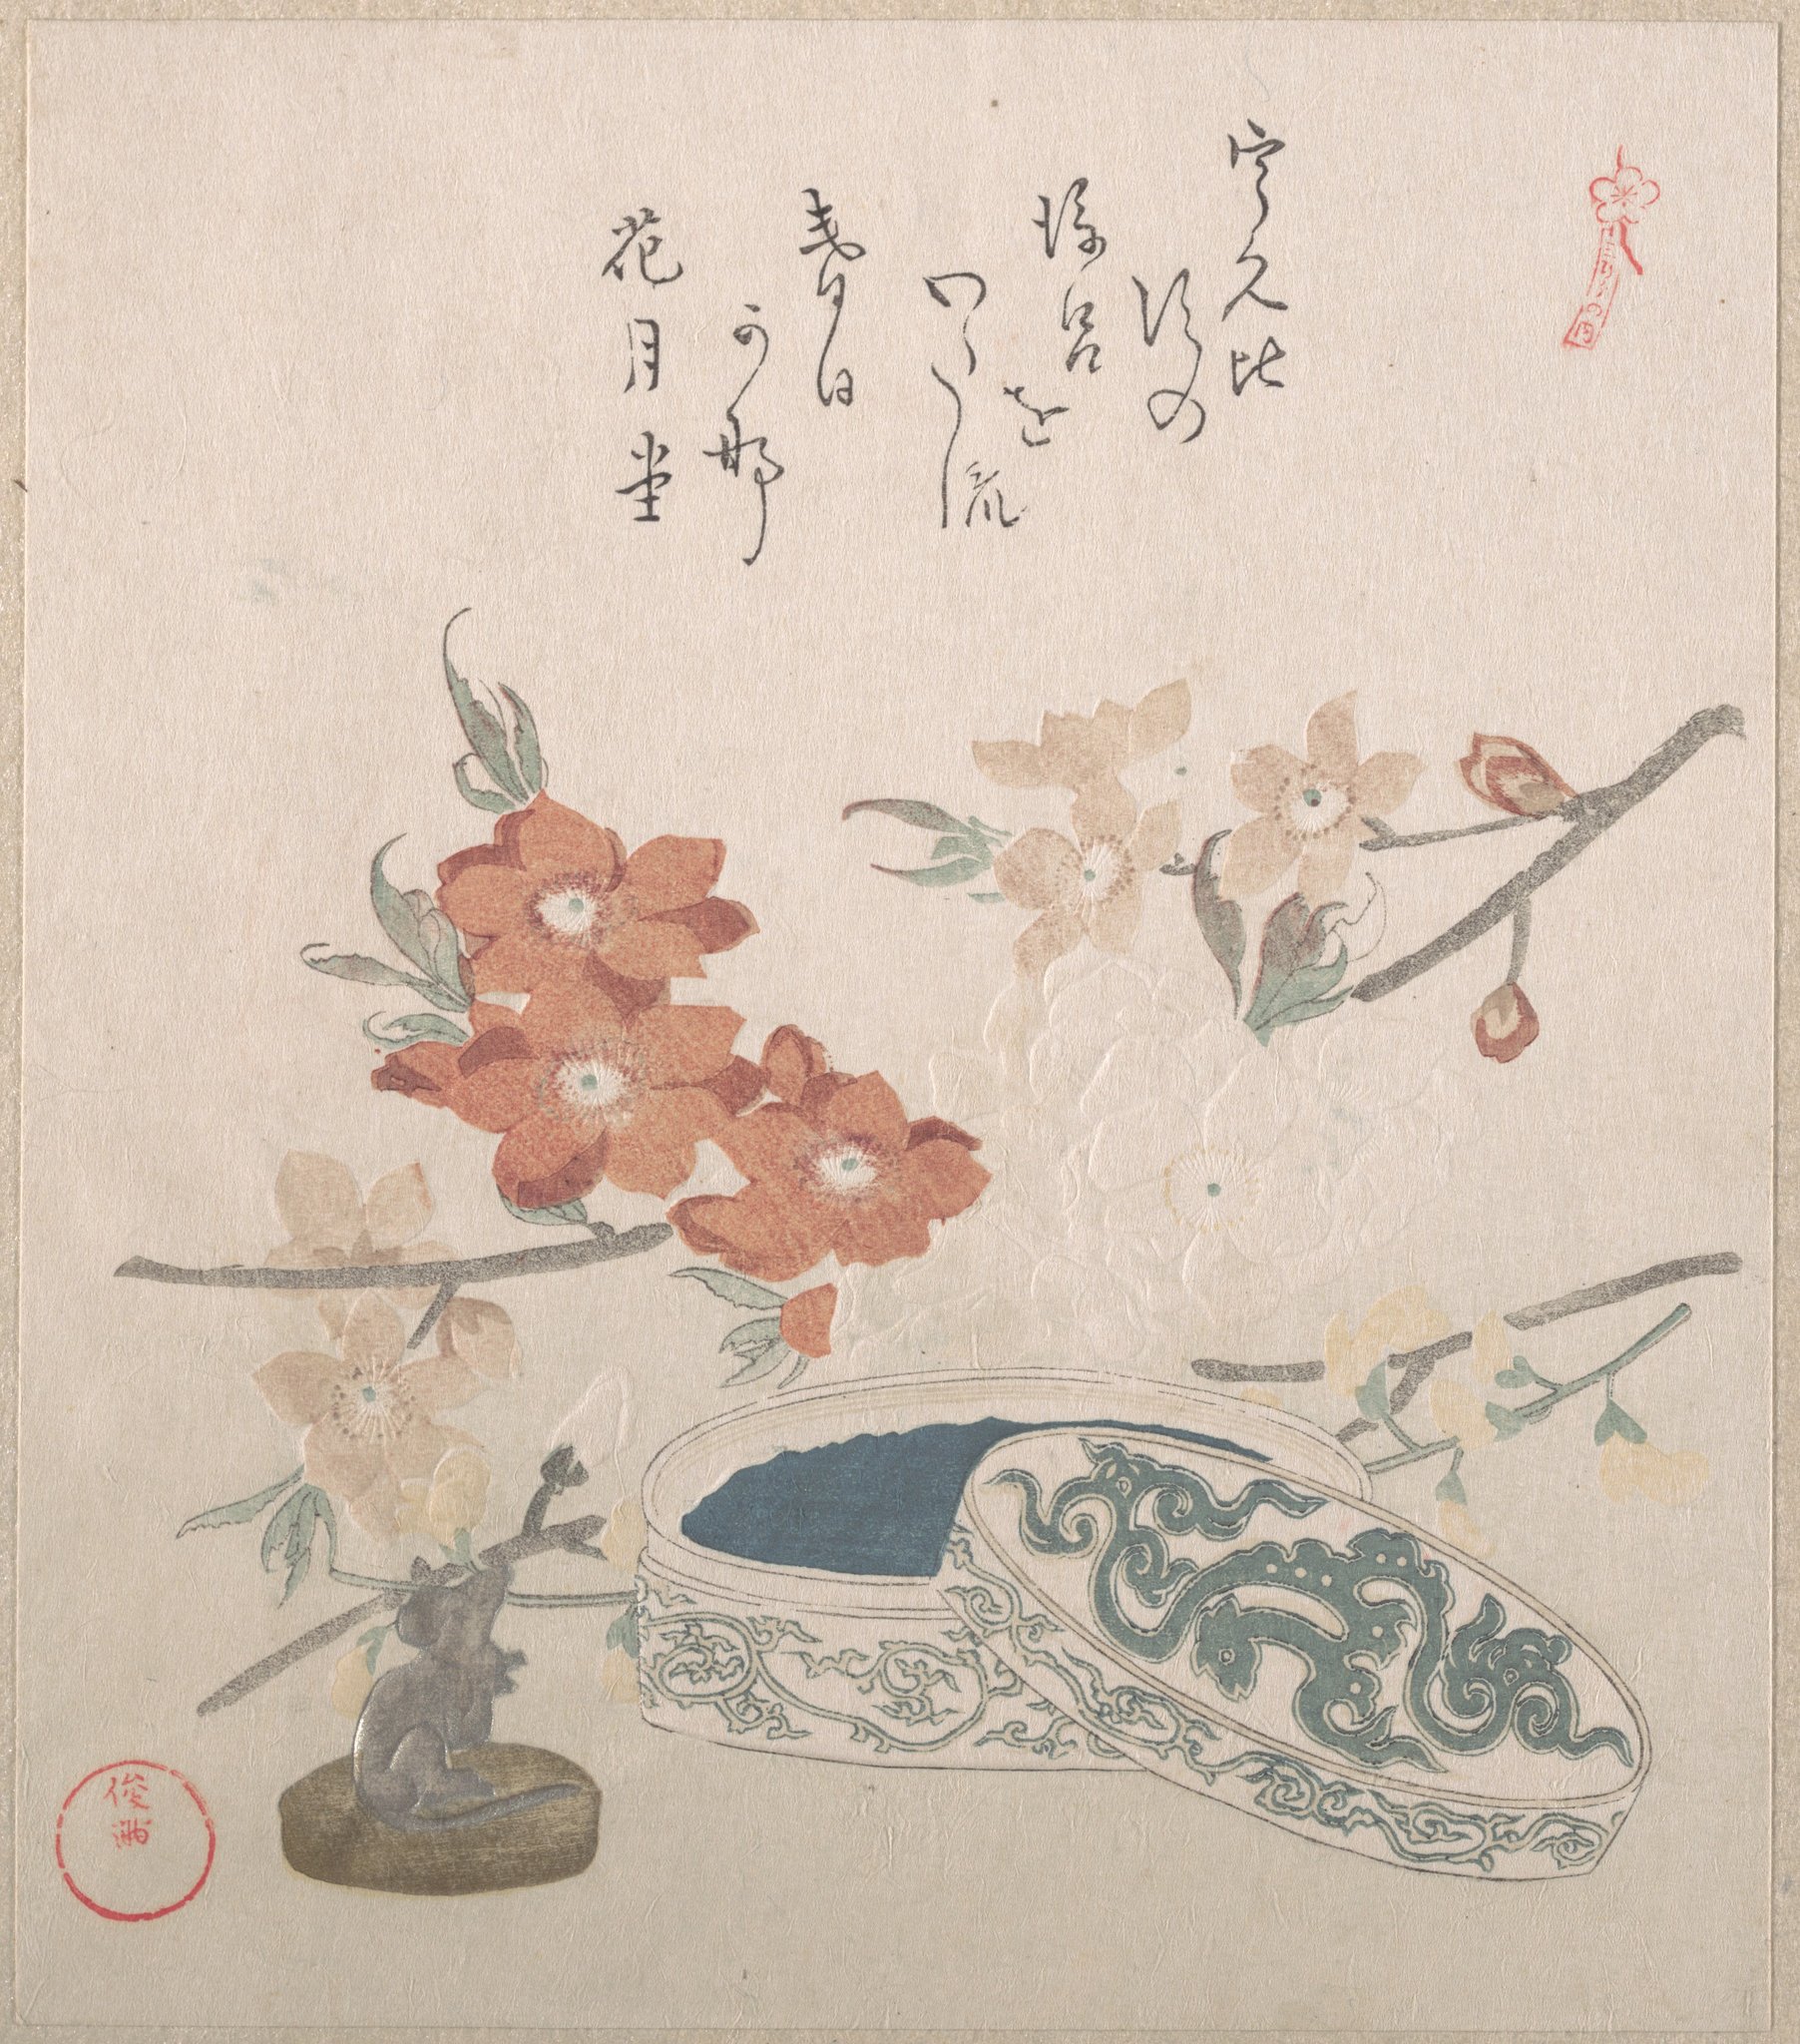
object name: woodblock print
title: Peach Blossoms, a Seal and a Seal-box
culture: japanese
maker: kubo shunman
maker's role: artist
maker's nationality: japanese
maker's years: 1757-1820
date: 1801-1900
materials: ink, paper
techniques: surimono, woodblock print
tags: flowers,seals,boxes